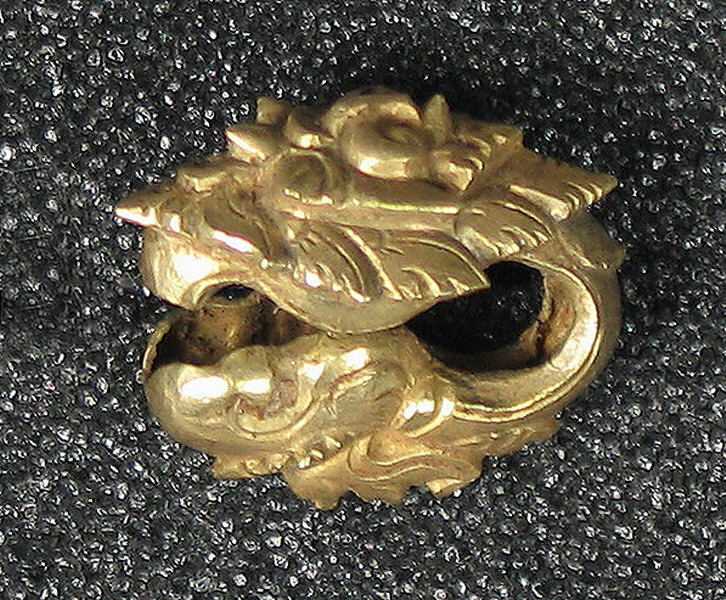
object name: earring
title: Earring with Foliate Decoration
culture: indonesian, central java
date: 701-1200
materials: gold